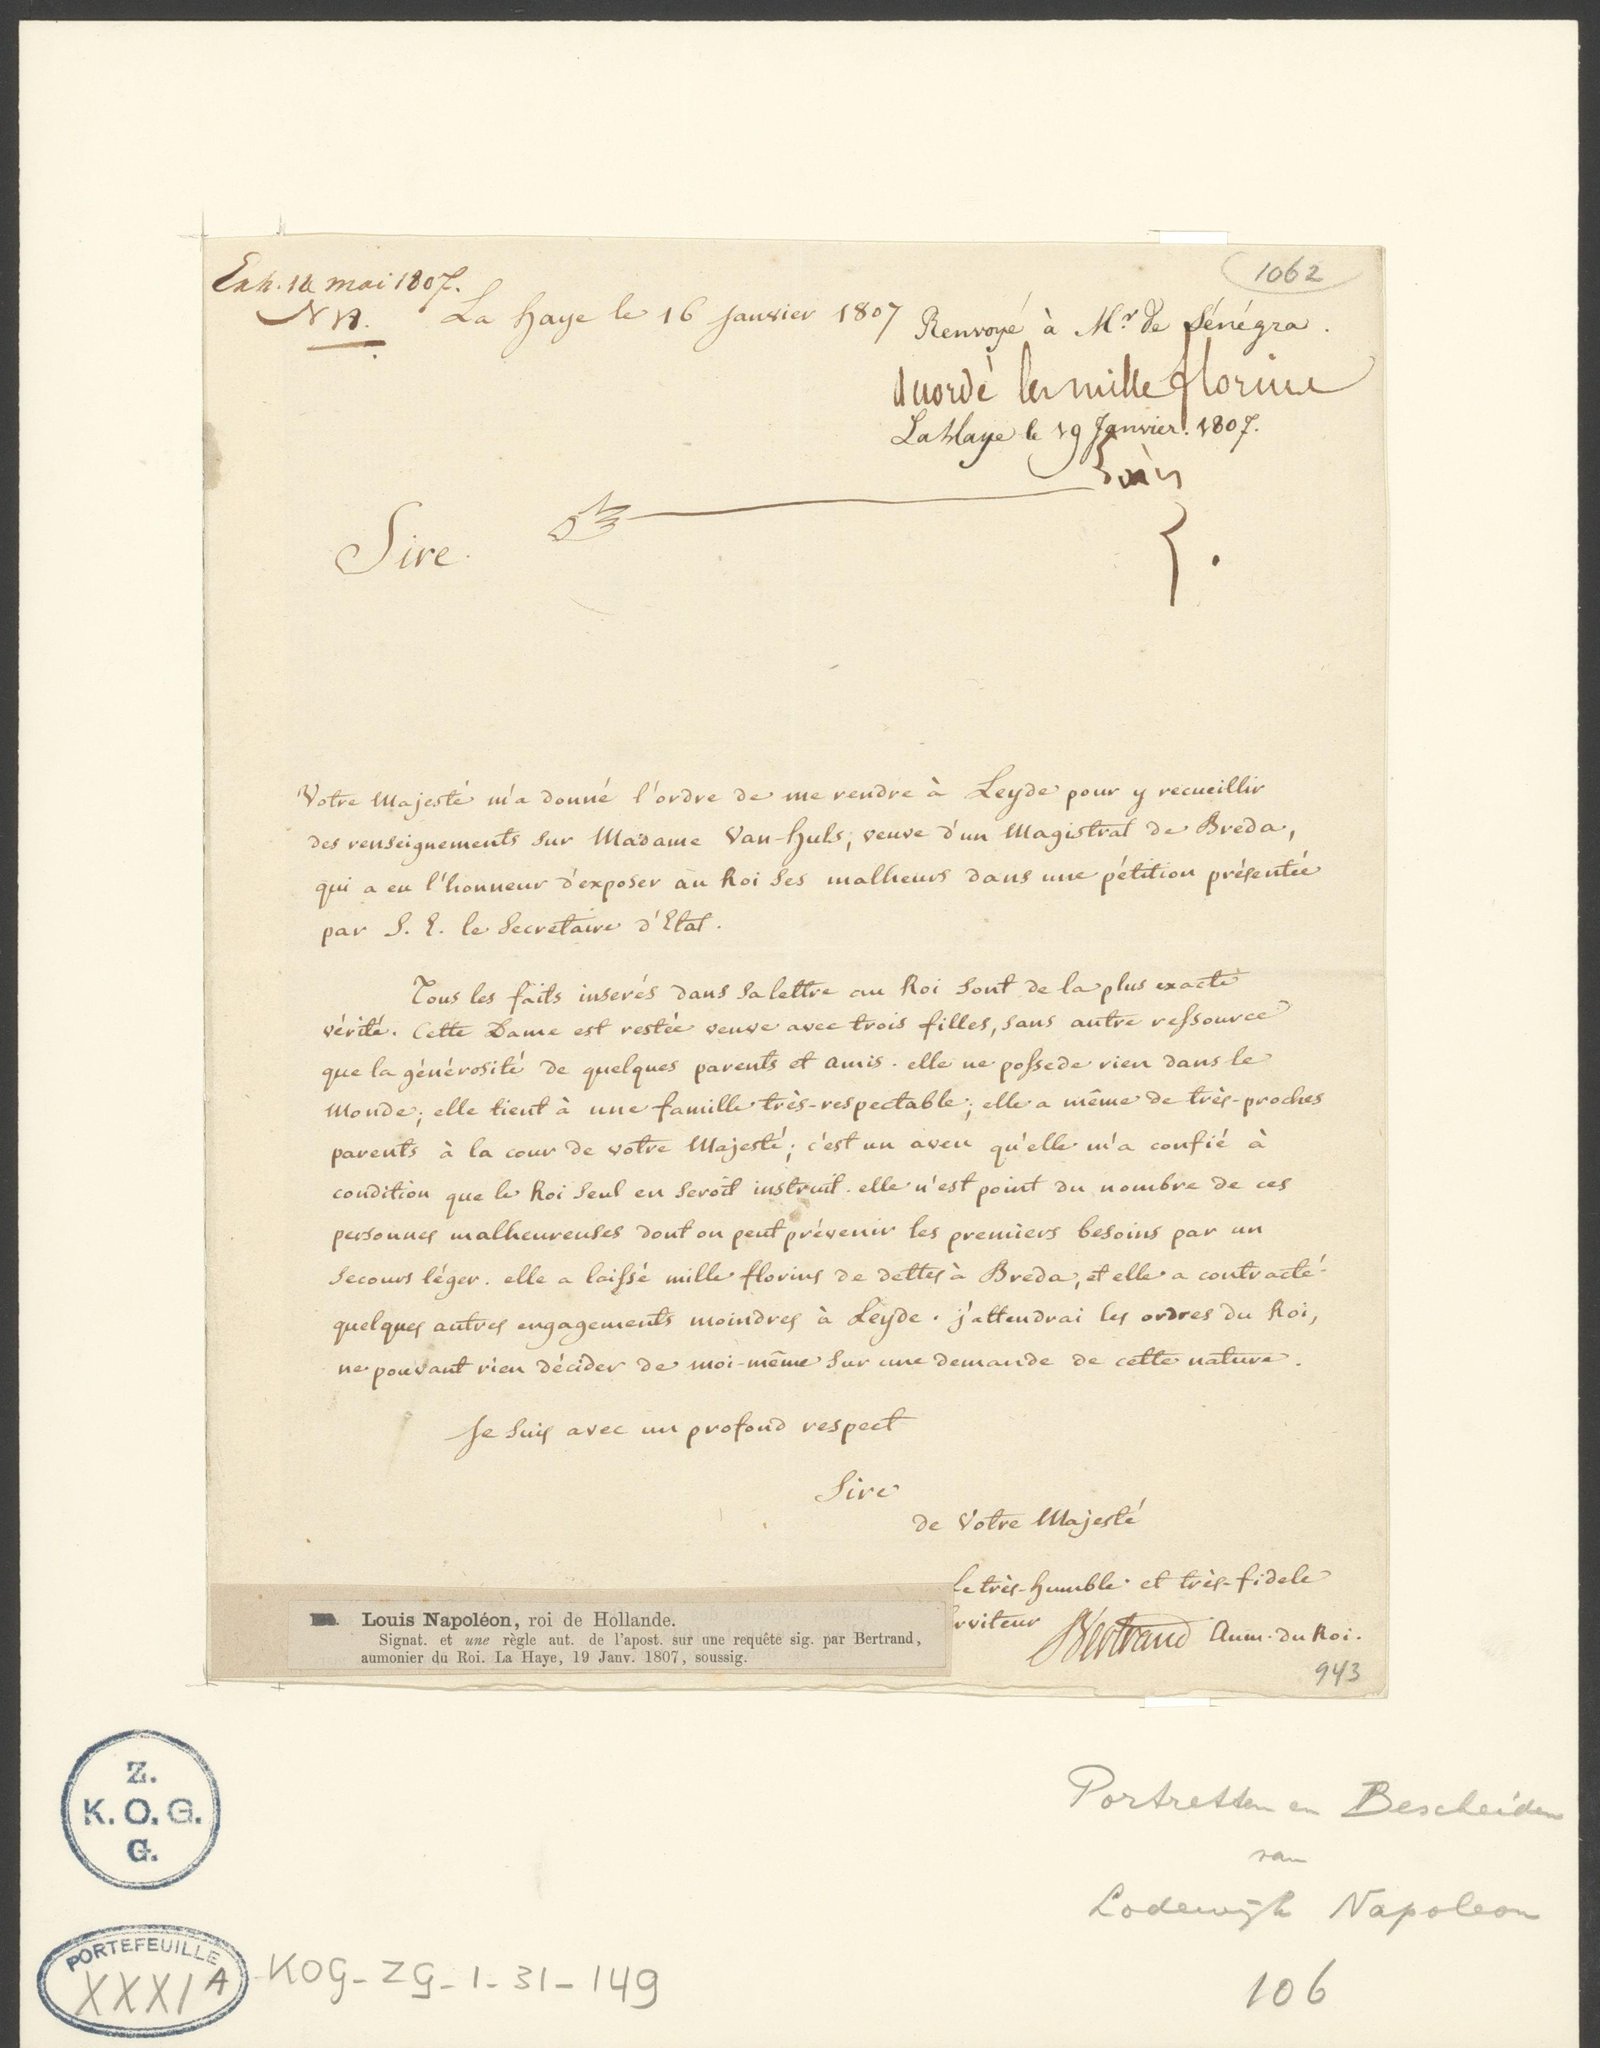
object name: letter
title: Brief aan Lodewijk Napoleon, koning van Holland over mevrouw Van Huls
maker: Anonymous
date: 1807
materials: ink, paper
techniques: pen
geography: the hague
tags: louis napoleon (king of holland)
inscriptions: signature: ‘Le très-humble et très-fidele Serviteur Bertrand, aum du Roi’, stamp, collector's mark: Lugt 1641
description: Brief aan Lodewijk Napoleon, koning van Holland en door Bertrand, de kapelaan van de koning over mevrouw Van Huls, weduwe van de magistraat van Breda. Bertrand was afgereisd naar Leiden om informatie in te winnen over mevrouw van Huls. Nadat haar man was overleden, bleef zij achter met drie kinderen. Bertrand schrijft dat zij een familieleden aan het hof heeft en dat zij veel hulp nodig heeft. Zij heeft in Breda schulden van duizenden florijnen en enkele kleinere schulden in Leiden. Onderwerpsrubrieken binnen de Atlas Zeden en Gewoonten: Portretten, Lodewijk Napoleon.